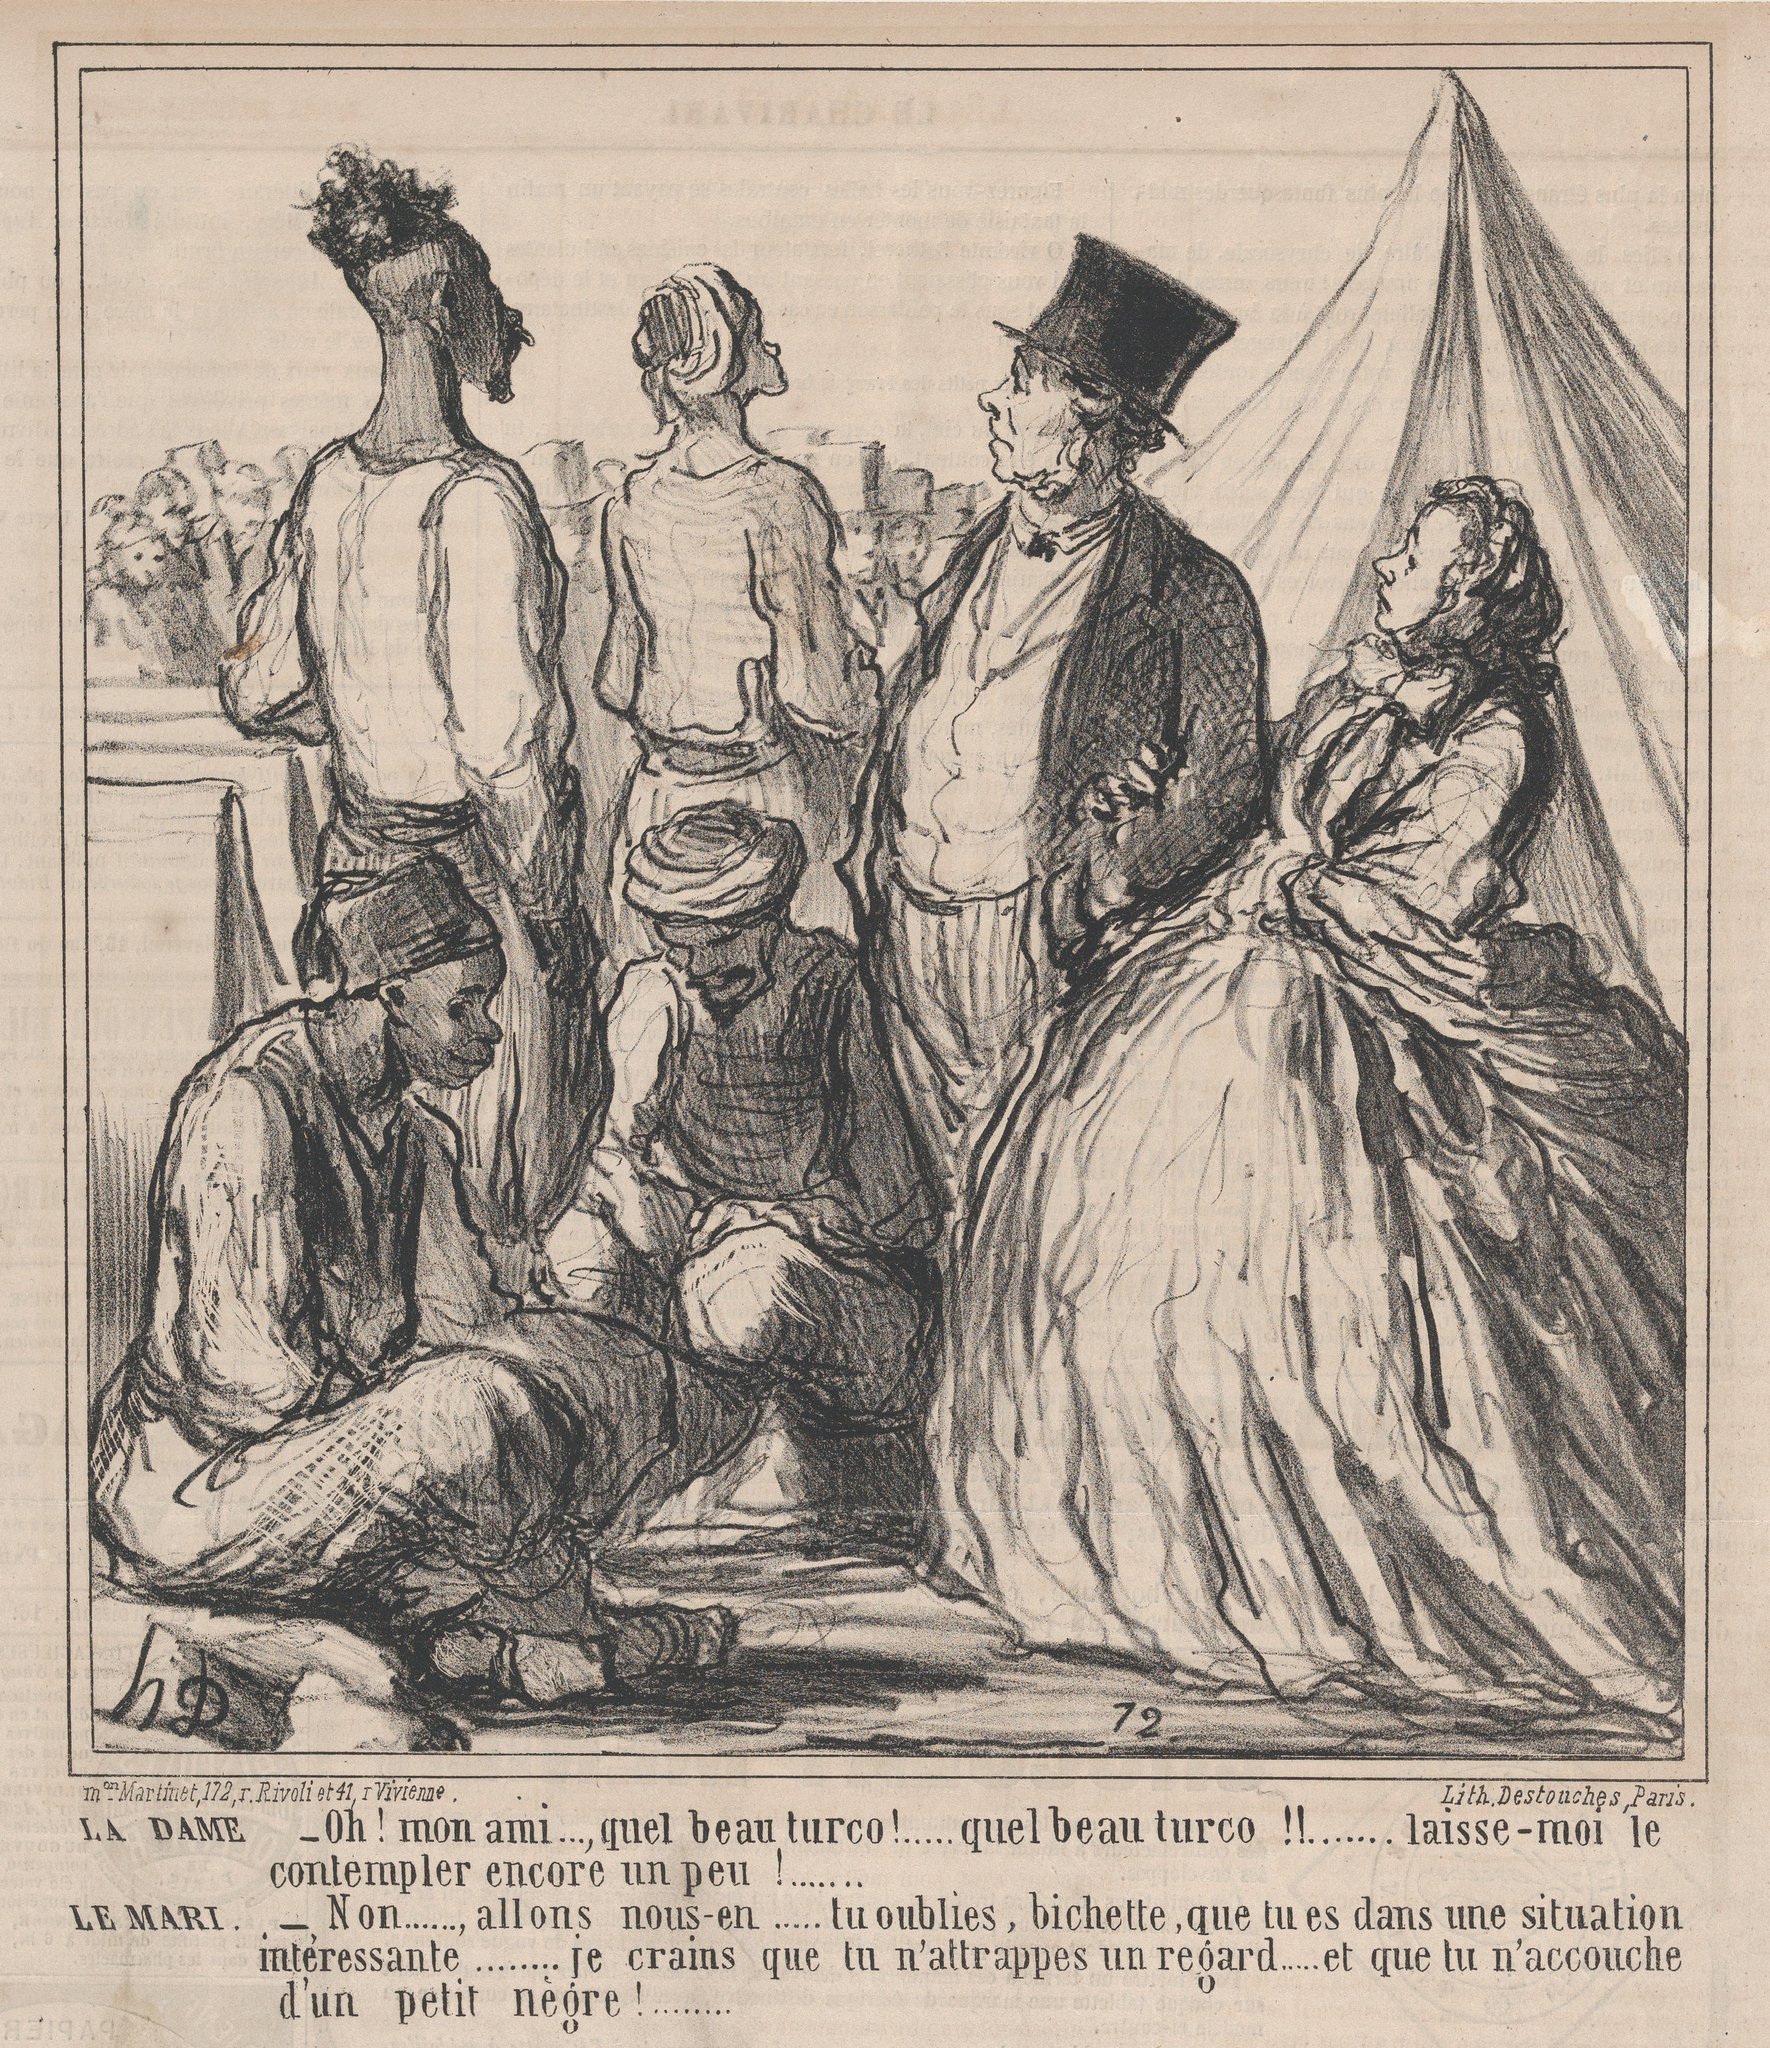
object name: print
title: Oh! mon ami..., quel beau turco!.... quel beau turco!!...., from Au Camp de Saint-Maur, published in Le Charivari, August 15, 1859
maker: honoré daumier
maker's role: artist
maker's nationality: french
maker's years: 1808-1879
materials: paper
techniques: lithograph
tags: men,women